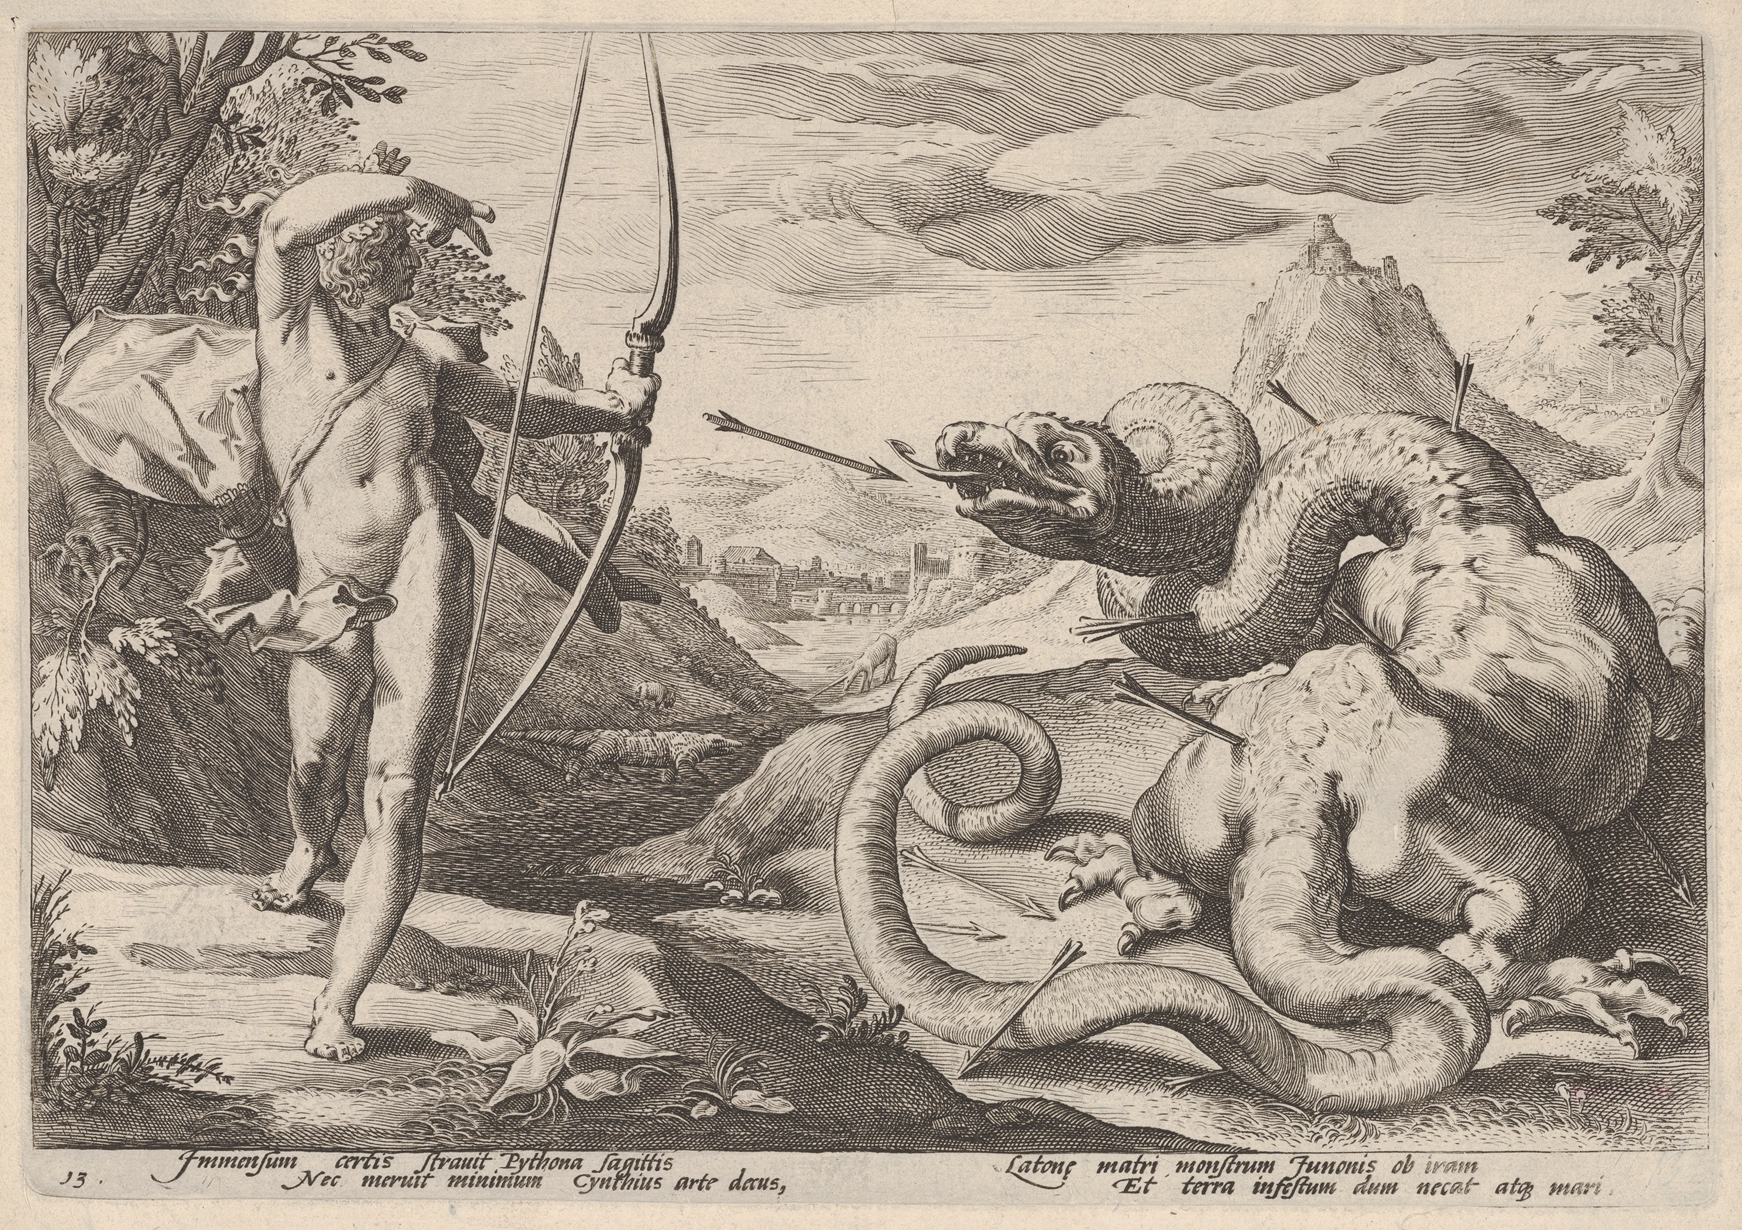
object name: print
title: Apollo Killing the Python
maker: robert willemsz de baudous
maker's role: artist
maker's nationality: netherlandish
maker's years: 1574-1659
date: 1565-1750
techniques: engraving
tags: bow and arrow,apollo,snakes